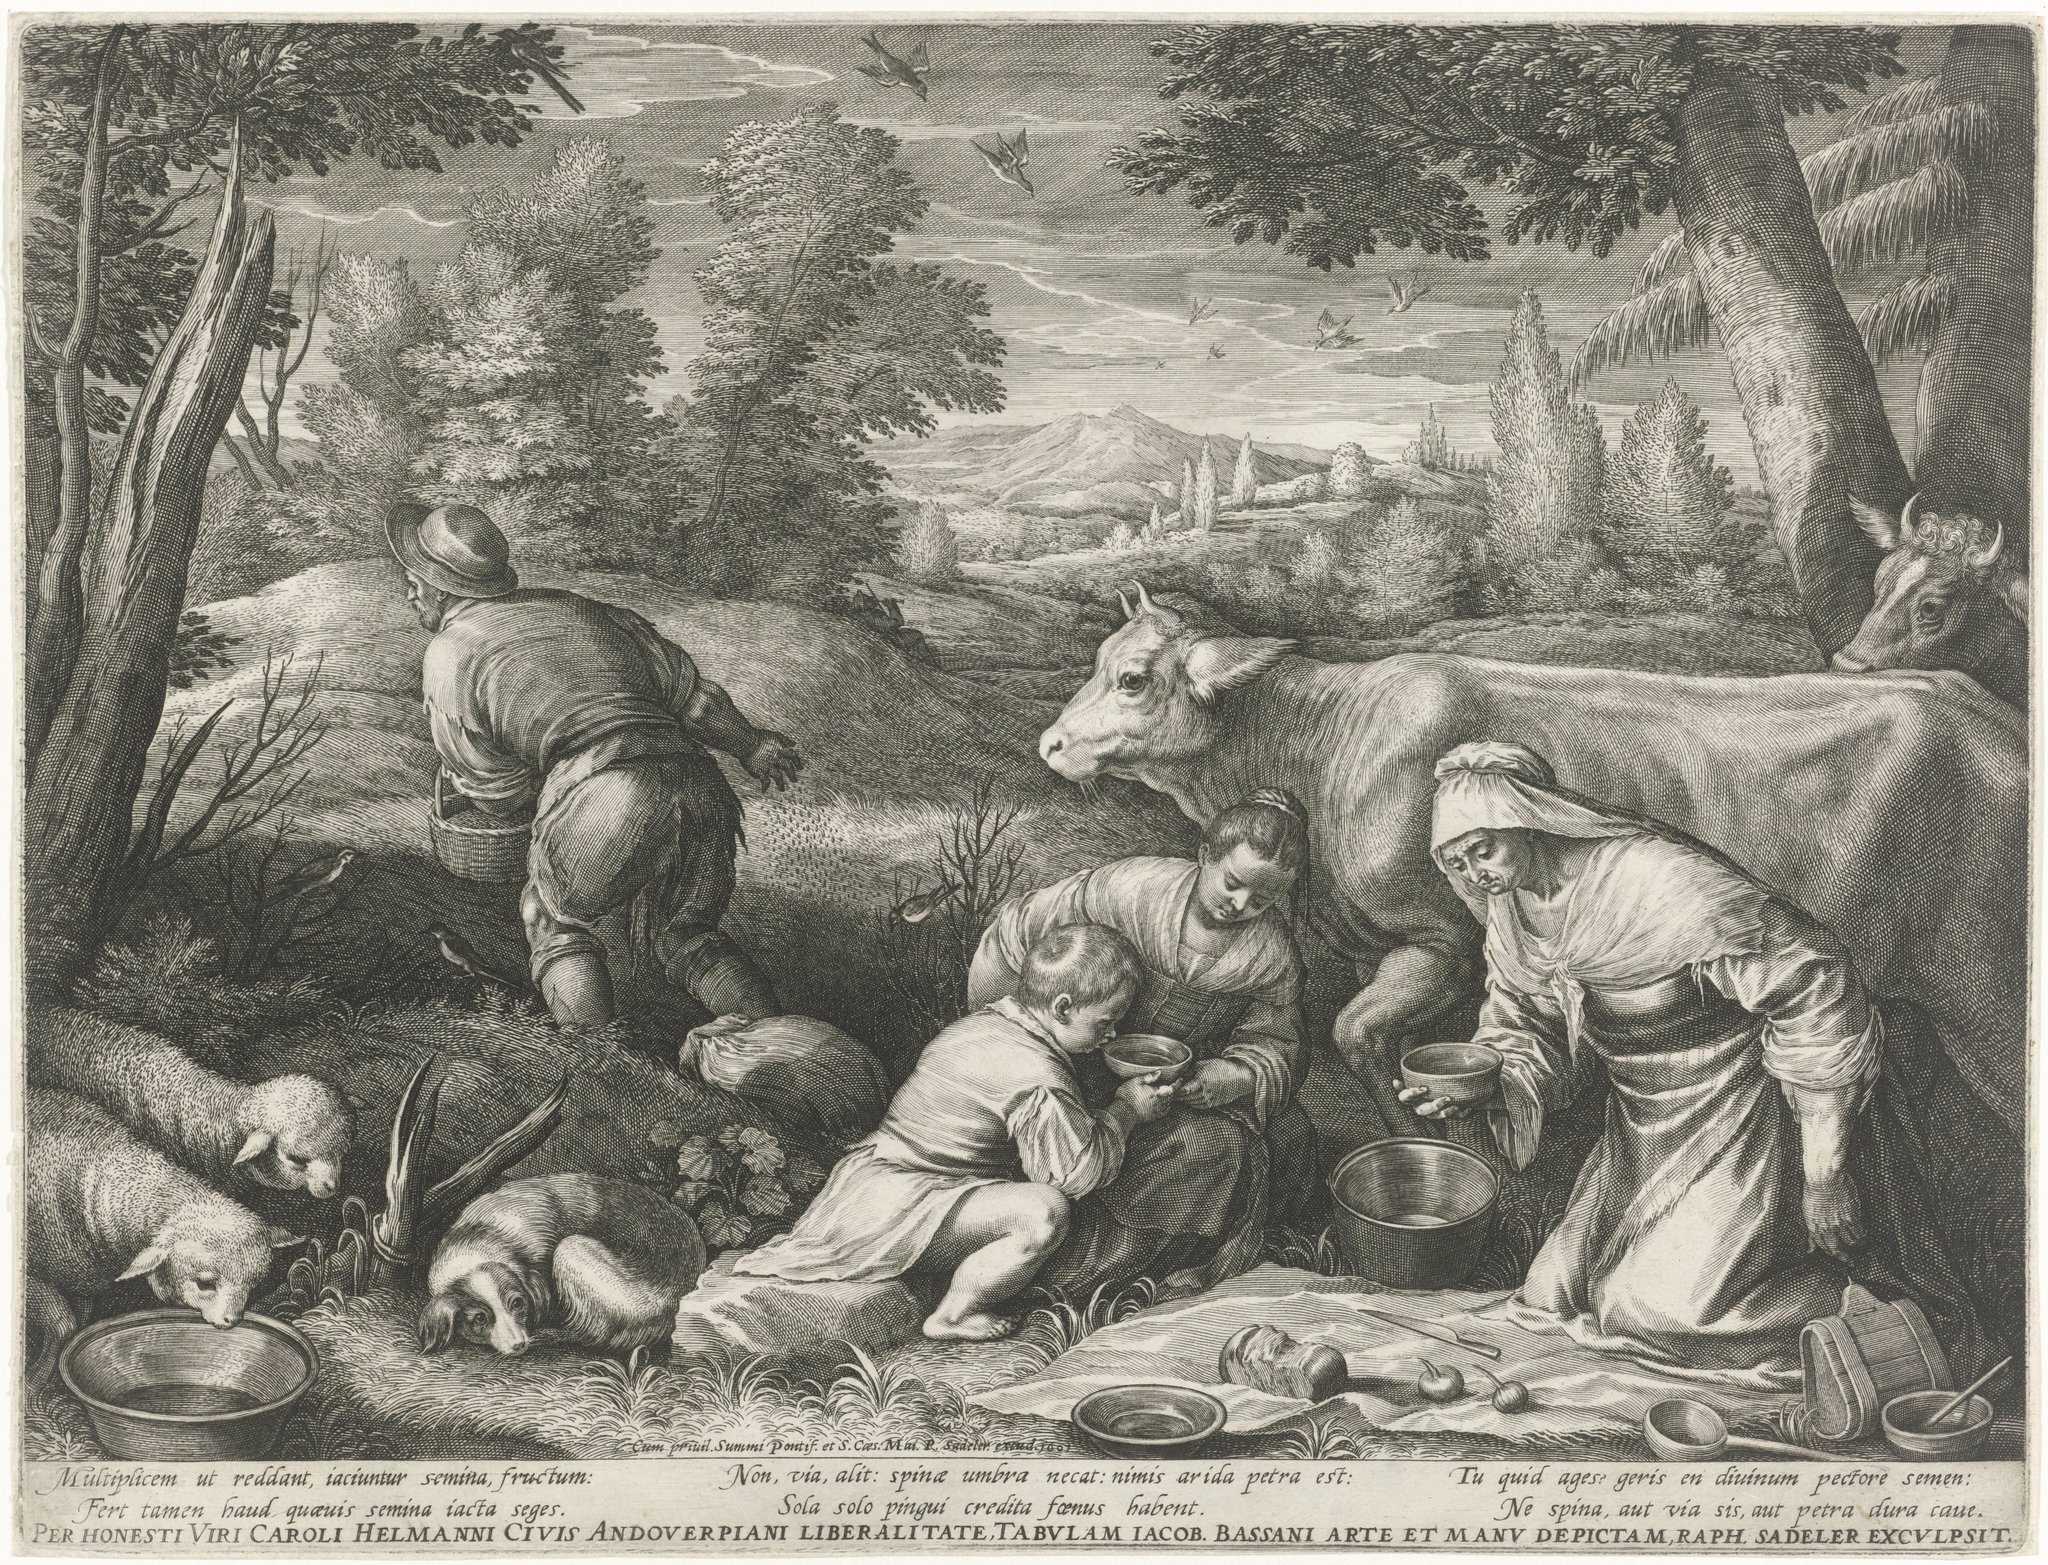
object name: print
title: De kleine melkmeid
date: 1601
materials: paper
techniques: engraving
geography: venice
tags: cow, herding, herdsman, herdswoman, shepherd, shepherdess, cowherd, etc., boy (child between toddler and youth), meadow, pasture, farmers, sheep, sowing, (family) meal - cc - out of doors, milkmaid, dog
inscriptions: collector's mark: Lugt 240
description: Op de voorgrond geniet een boerengezin van een maaltijd in een weide. Een vrouw geeft een kom met melk aan een kleine jongen. Een andere vrouw heeft eveneens een kop met melk. Naast hen twee schapen en een hond. Achter het gezin een koe. Links is een man aan het zaaien. Op de achtergrond speelt een herder de fluit al liggend in het gras.